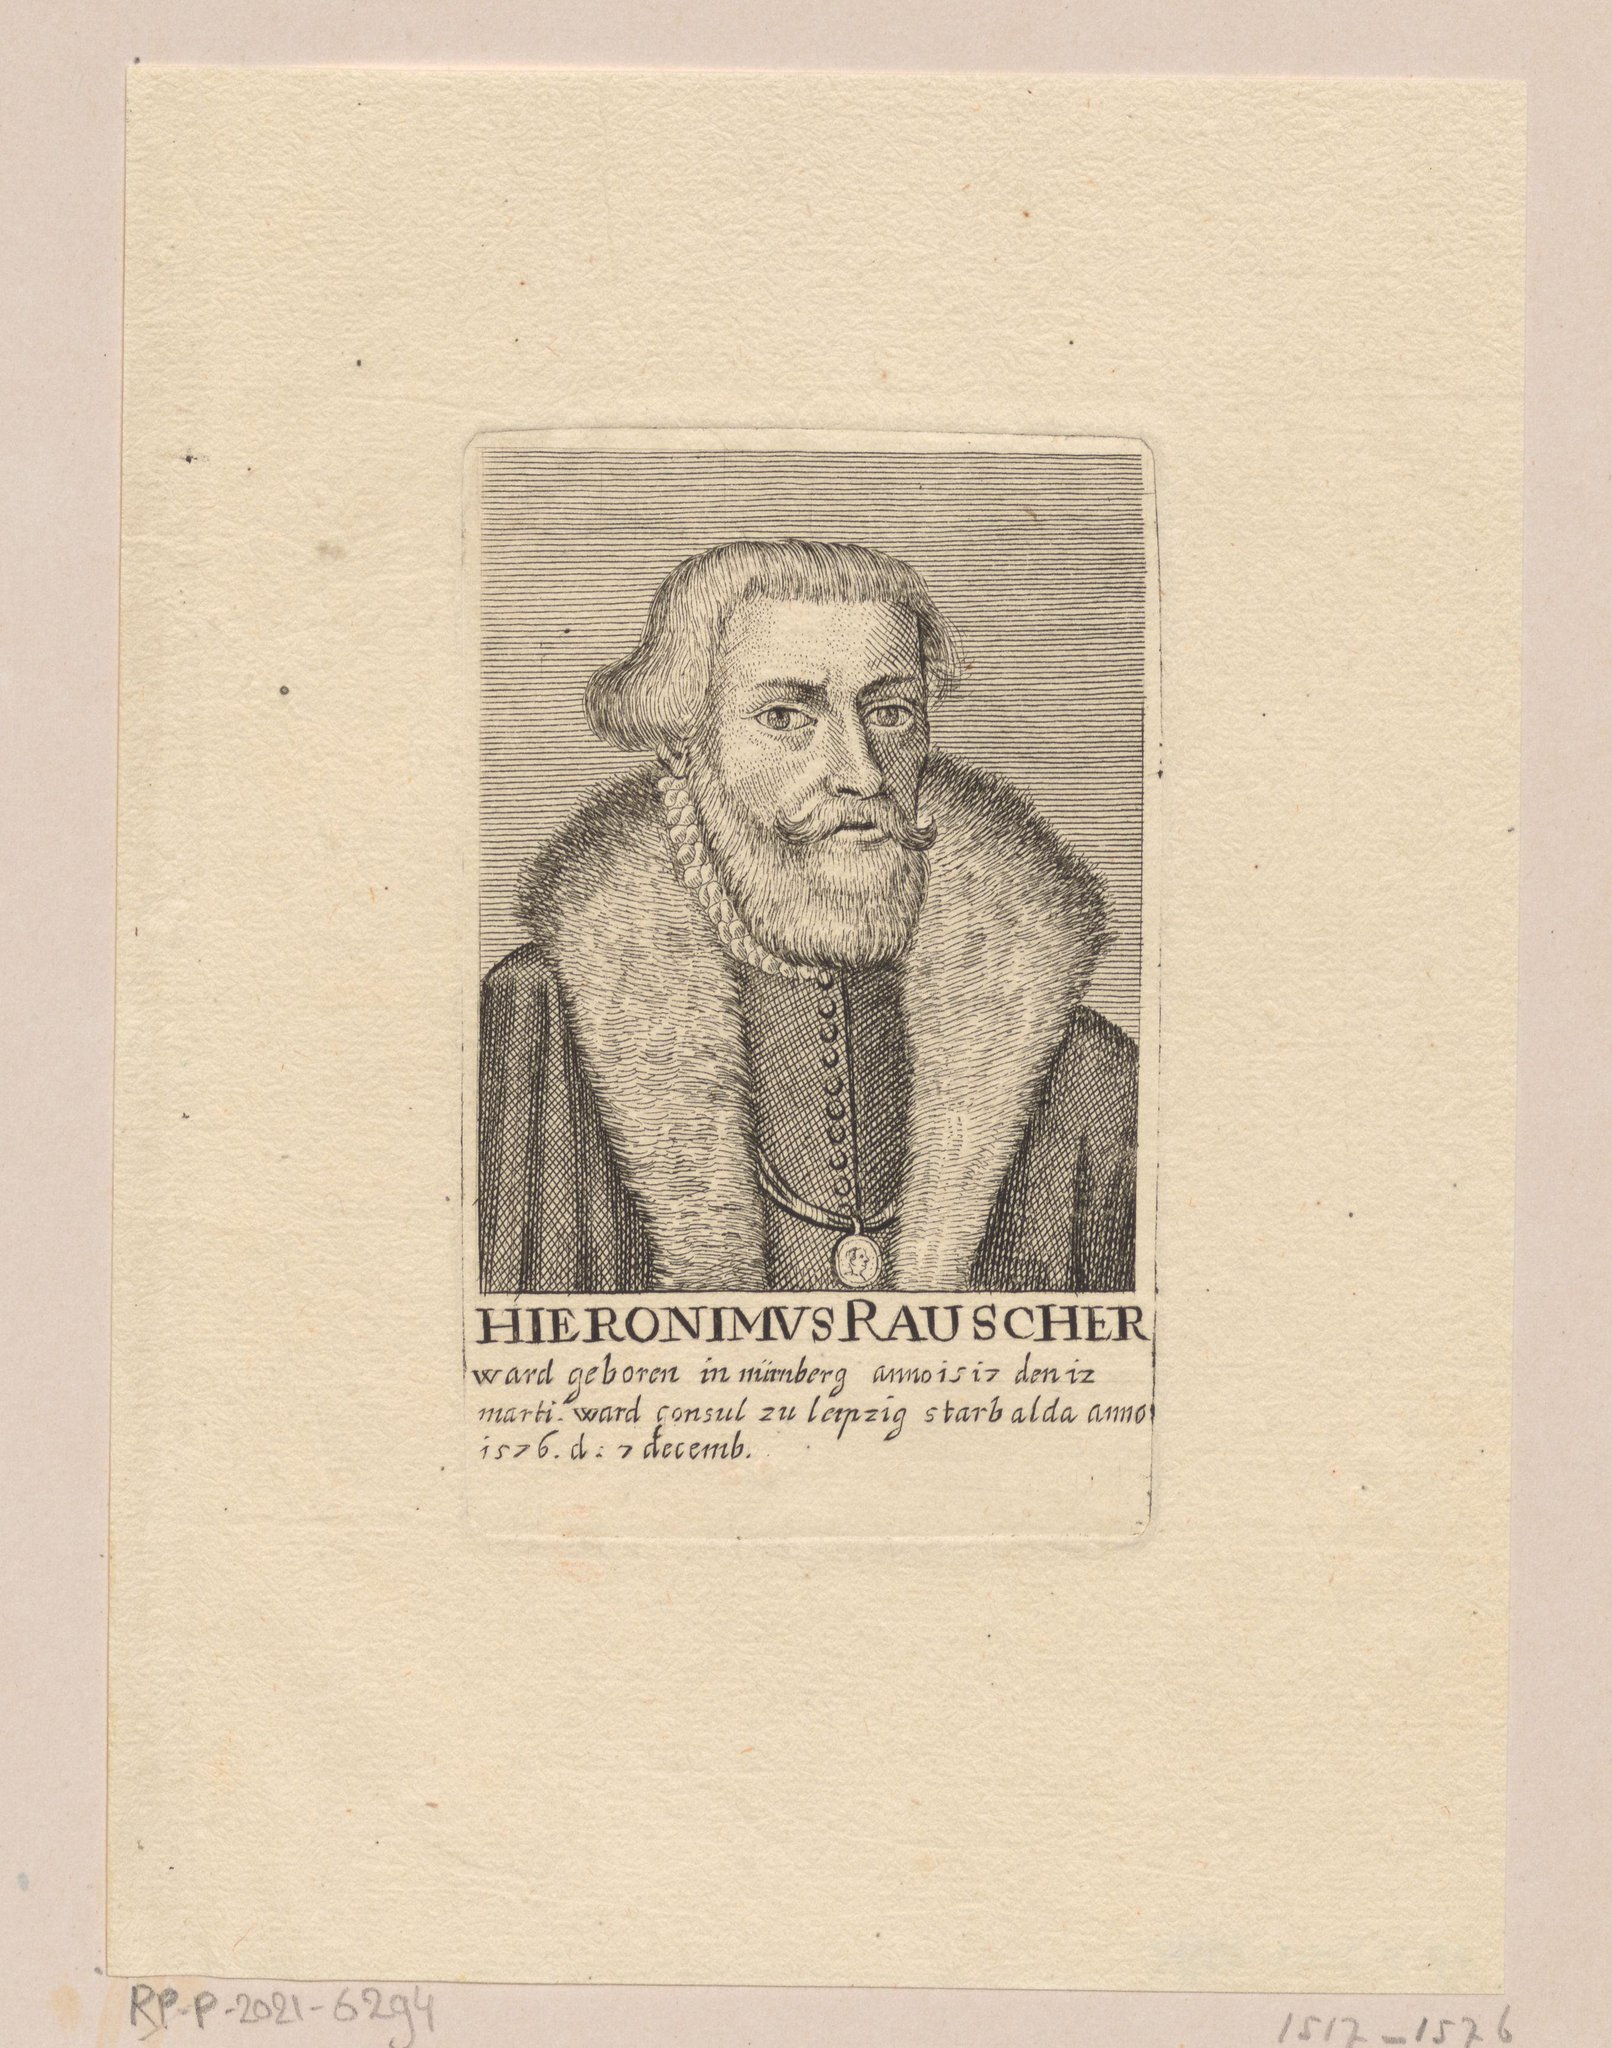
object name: print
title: Portret van Hieronymus Rauscher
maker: Anonymous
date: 1650-1749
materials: paper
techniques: engraving, etching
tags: amberg, historical persons